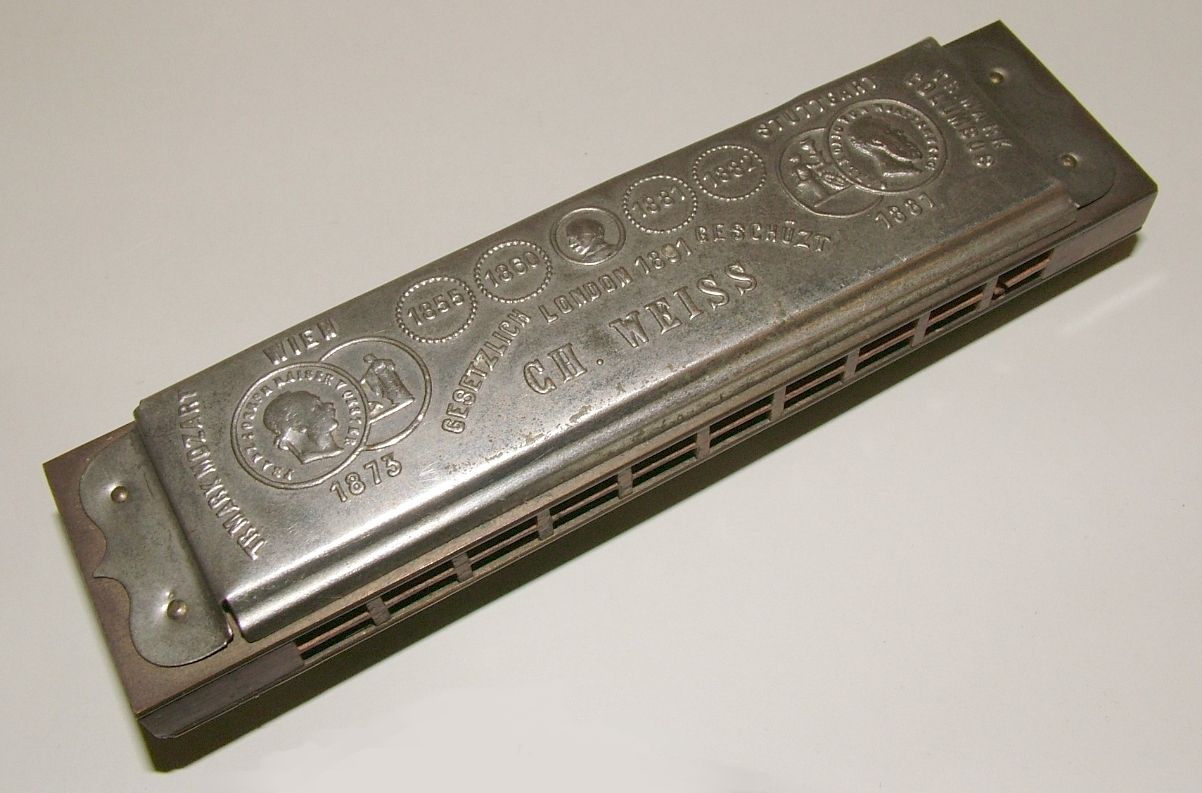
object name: harmonica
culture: german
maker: ch. weiss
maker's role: maker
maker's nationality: german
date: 1895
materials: metal, wood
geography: germany